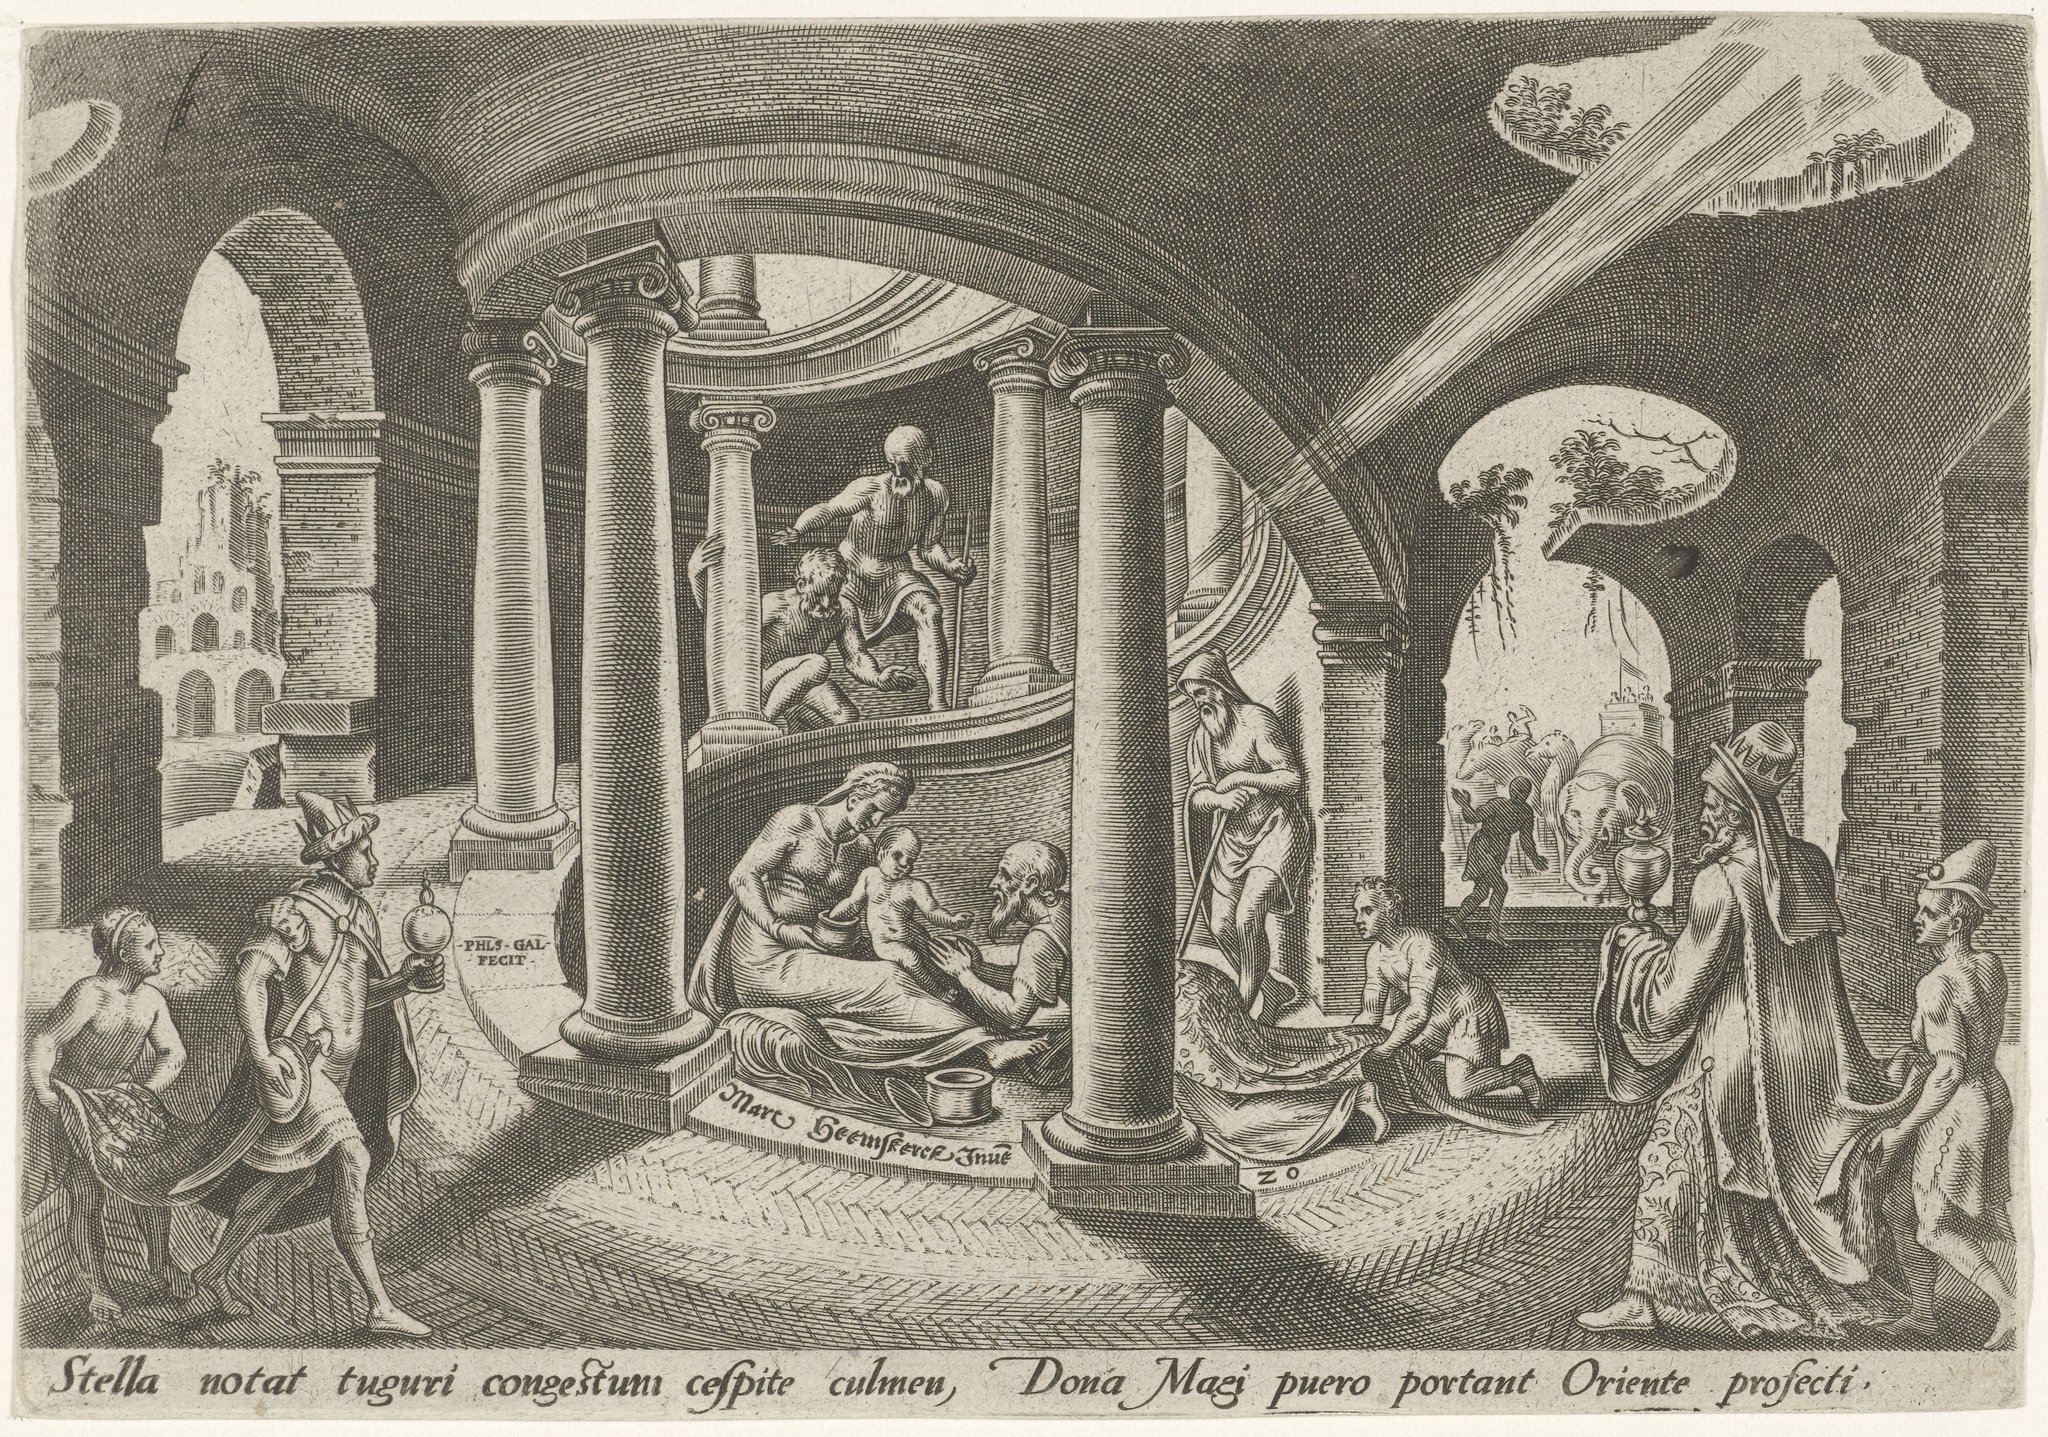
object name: print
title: De onheilsdagen van het Joodse volk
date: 1569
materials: paper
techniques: engraving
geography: haarlem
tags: adoration of the kings: the wise men present their gifts to the christ-child (gold, frankincense and myrrh)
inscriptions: signature: ‘Phs. Gal fecit’, caption: ‘Stella notat tuguri congestum cespite culmen...Oriente profecti’, number: ‘20’, signature: ‘Mart Heemskerck Inve[ntor]’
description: In het atrium van een tempel zit Maria met het Kind en Jozef. Een van de drie koningen zit geknield voor hen. De anderen komen aanlopen van rechts en links. Een lichtstraal valt naar binnen door een gat in het plafond.